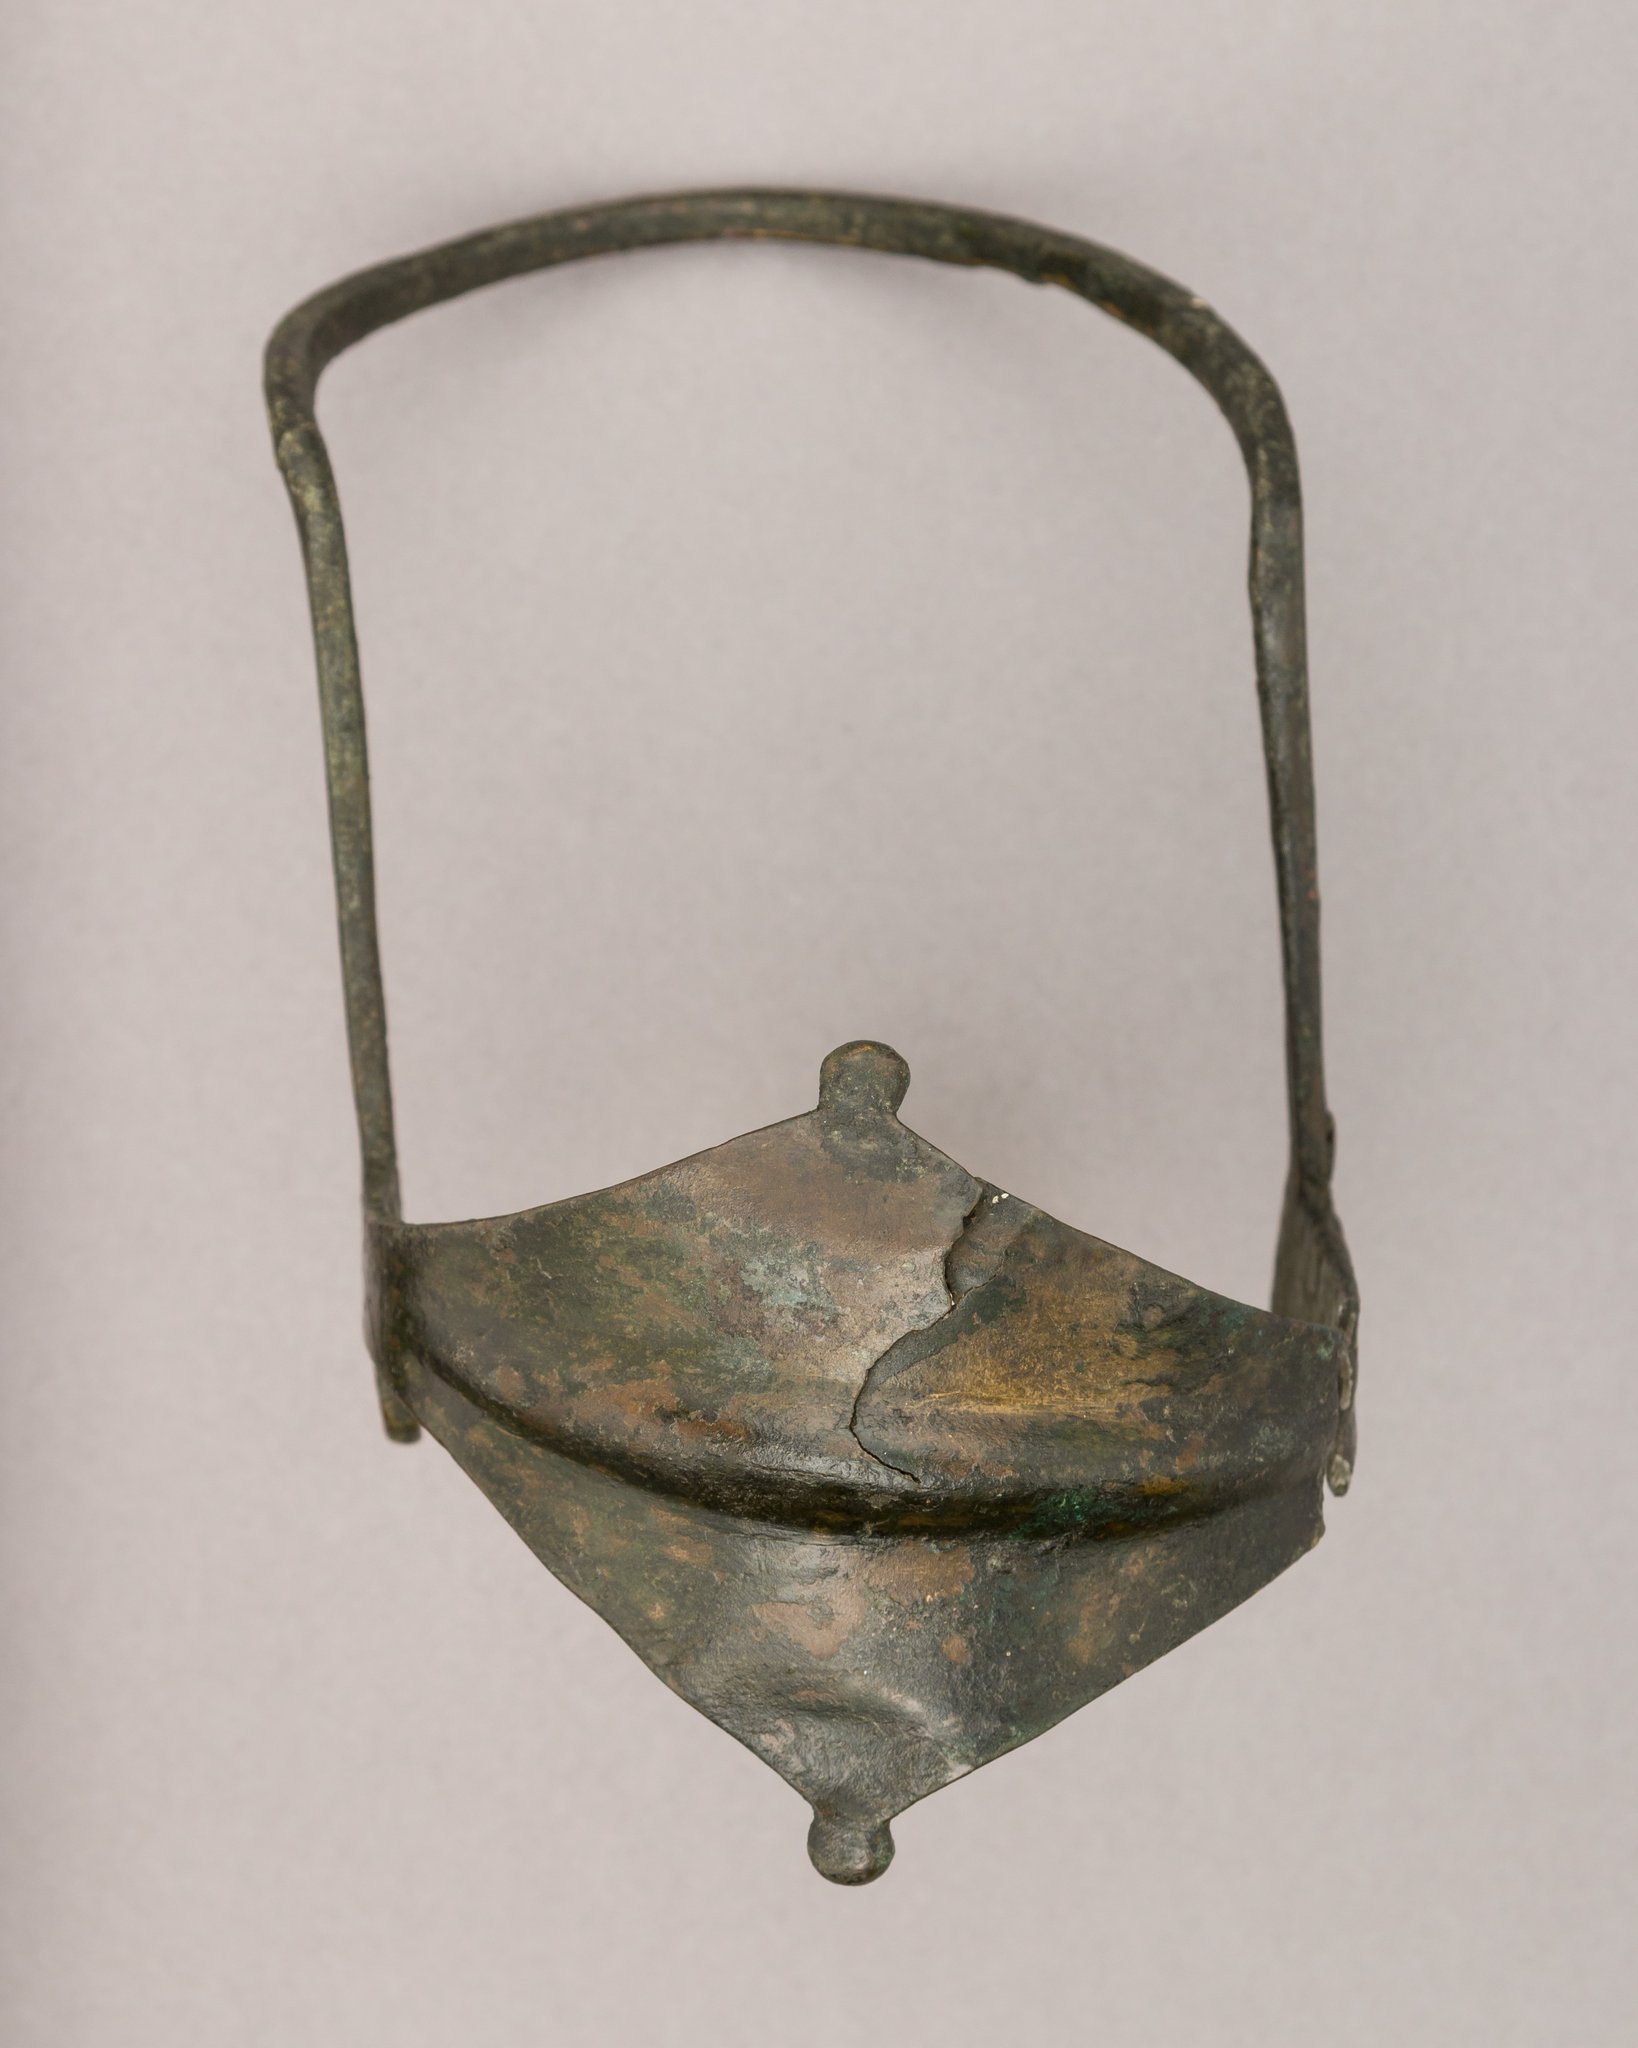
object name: cavesson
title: Cavesson (Psálion)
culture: roman or thracian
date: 1-200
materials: copper alloy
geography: italy